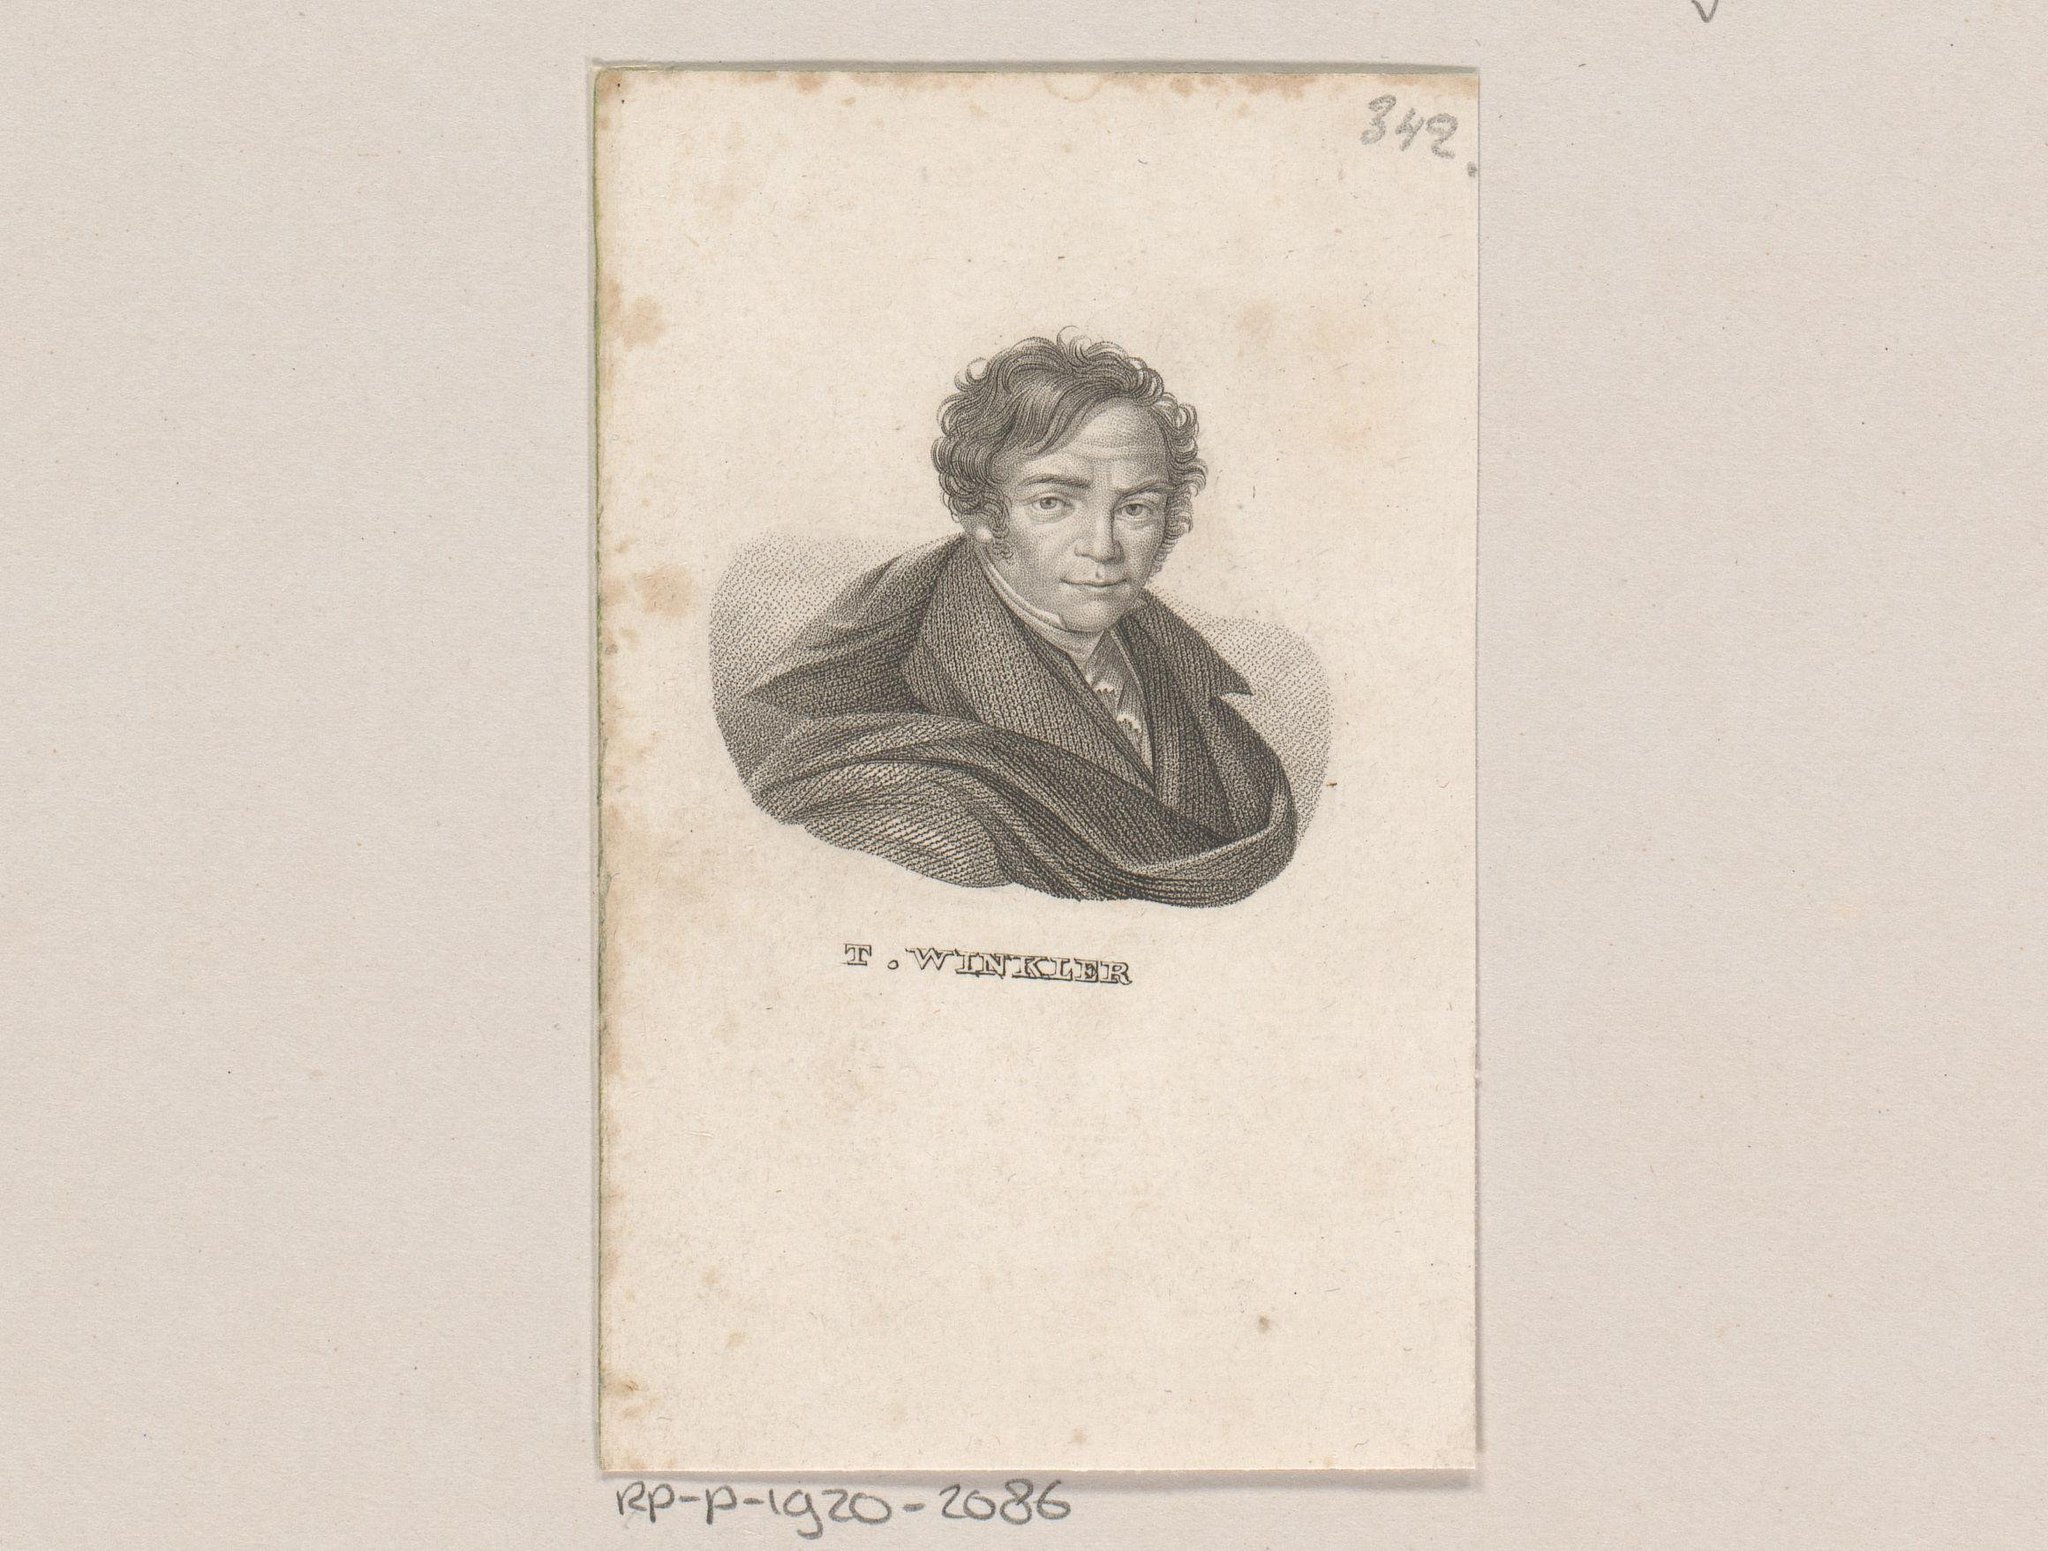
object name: print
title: T. Winkler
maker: Anonymous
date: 1805-1856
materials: paper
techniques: etching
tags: historical persons, portrait of a writer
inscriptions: collector's mark: Lugt 2228